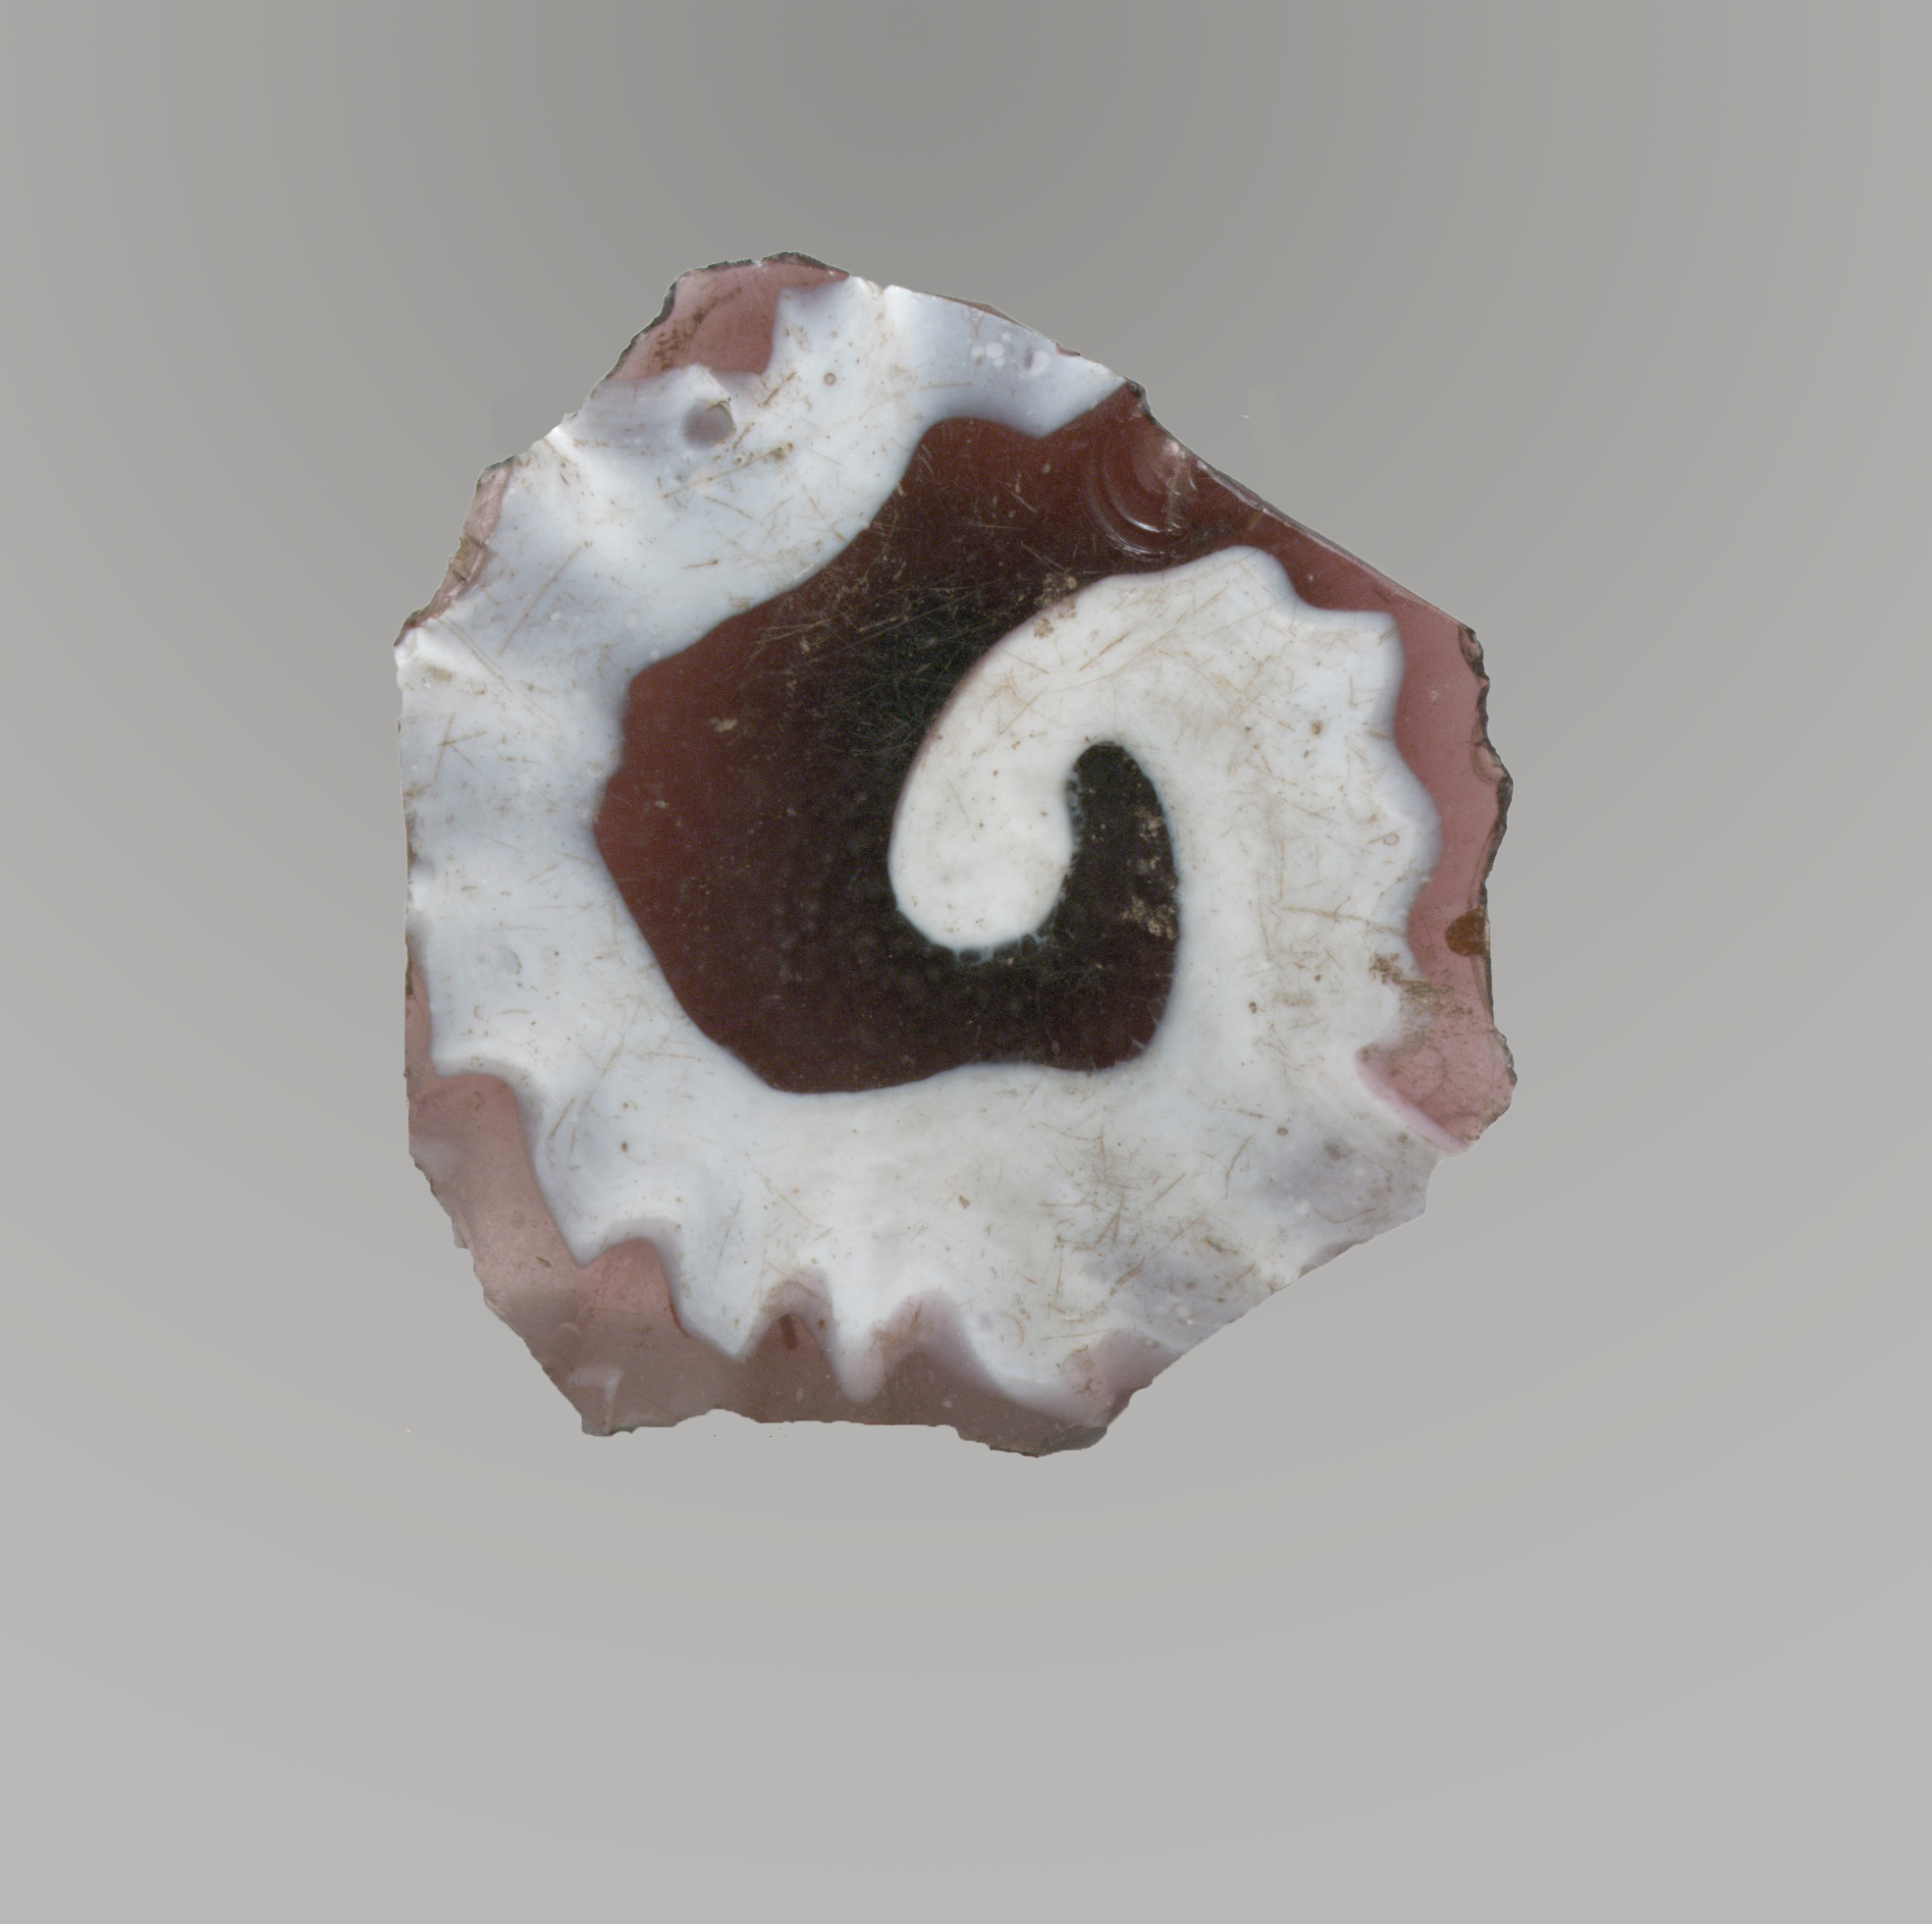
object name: fragment, bowl, rippenschale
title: Glass ribbed bowl fragment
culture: roman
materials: glass